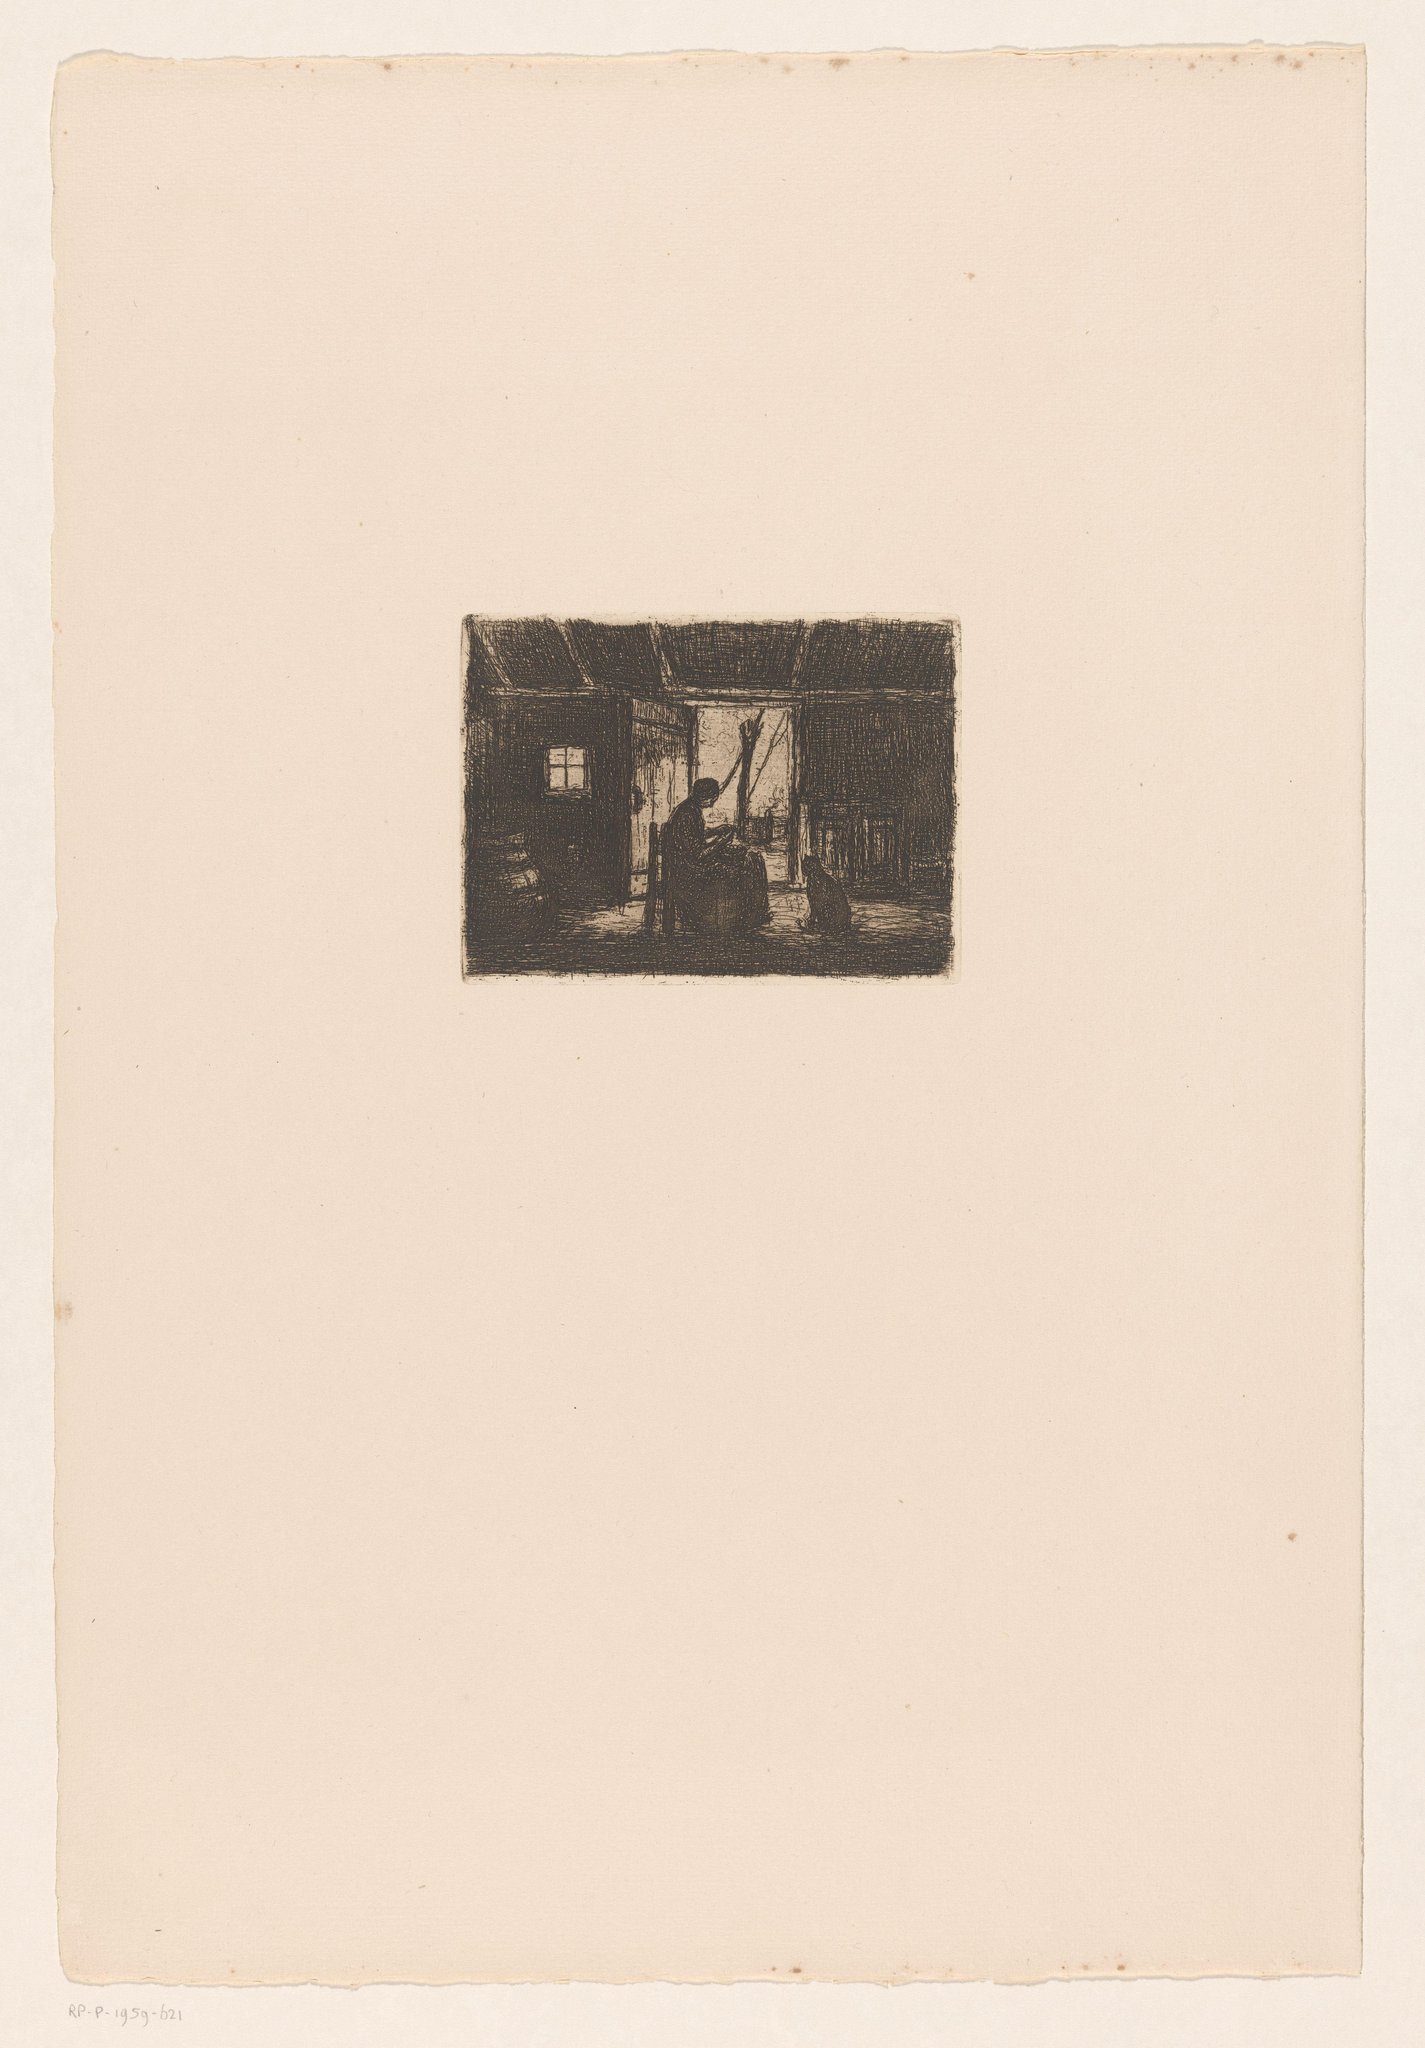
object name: print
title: Interieur met aardappelschillende vrouw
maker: jakob smits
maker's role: draughtsman, print maker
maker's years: 1855-1928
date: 1901-1925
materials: paper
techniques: etching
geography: netherlands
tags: interior of the house, cleaning vegetables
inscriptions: collector's mark: Lugt 2228, collector's mark: Lugt 2760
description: Naast de vrouw op de grond zit een kat of een hond.